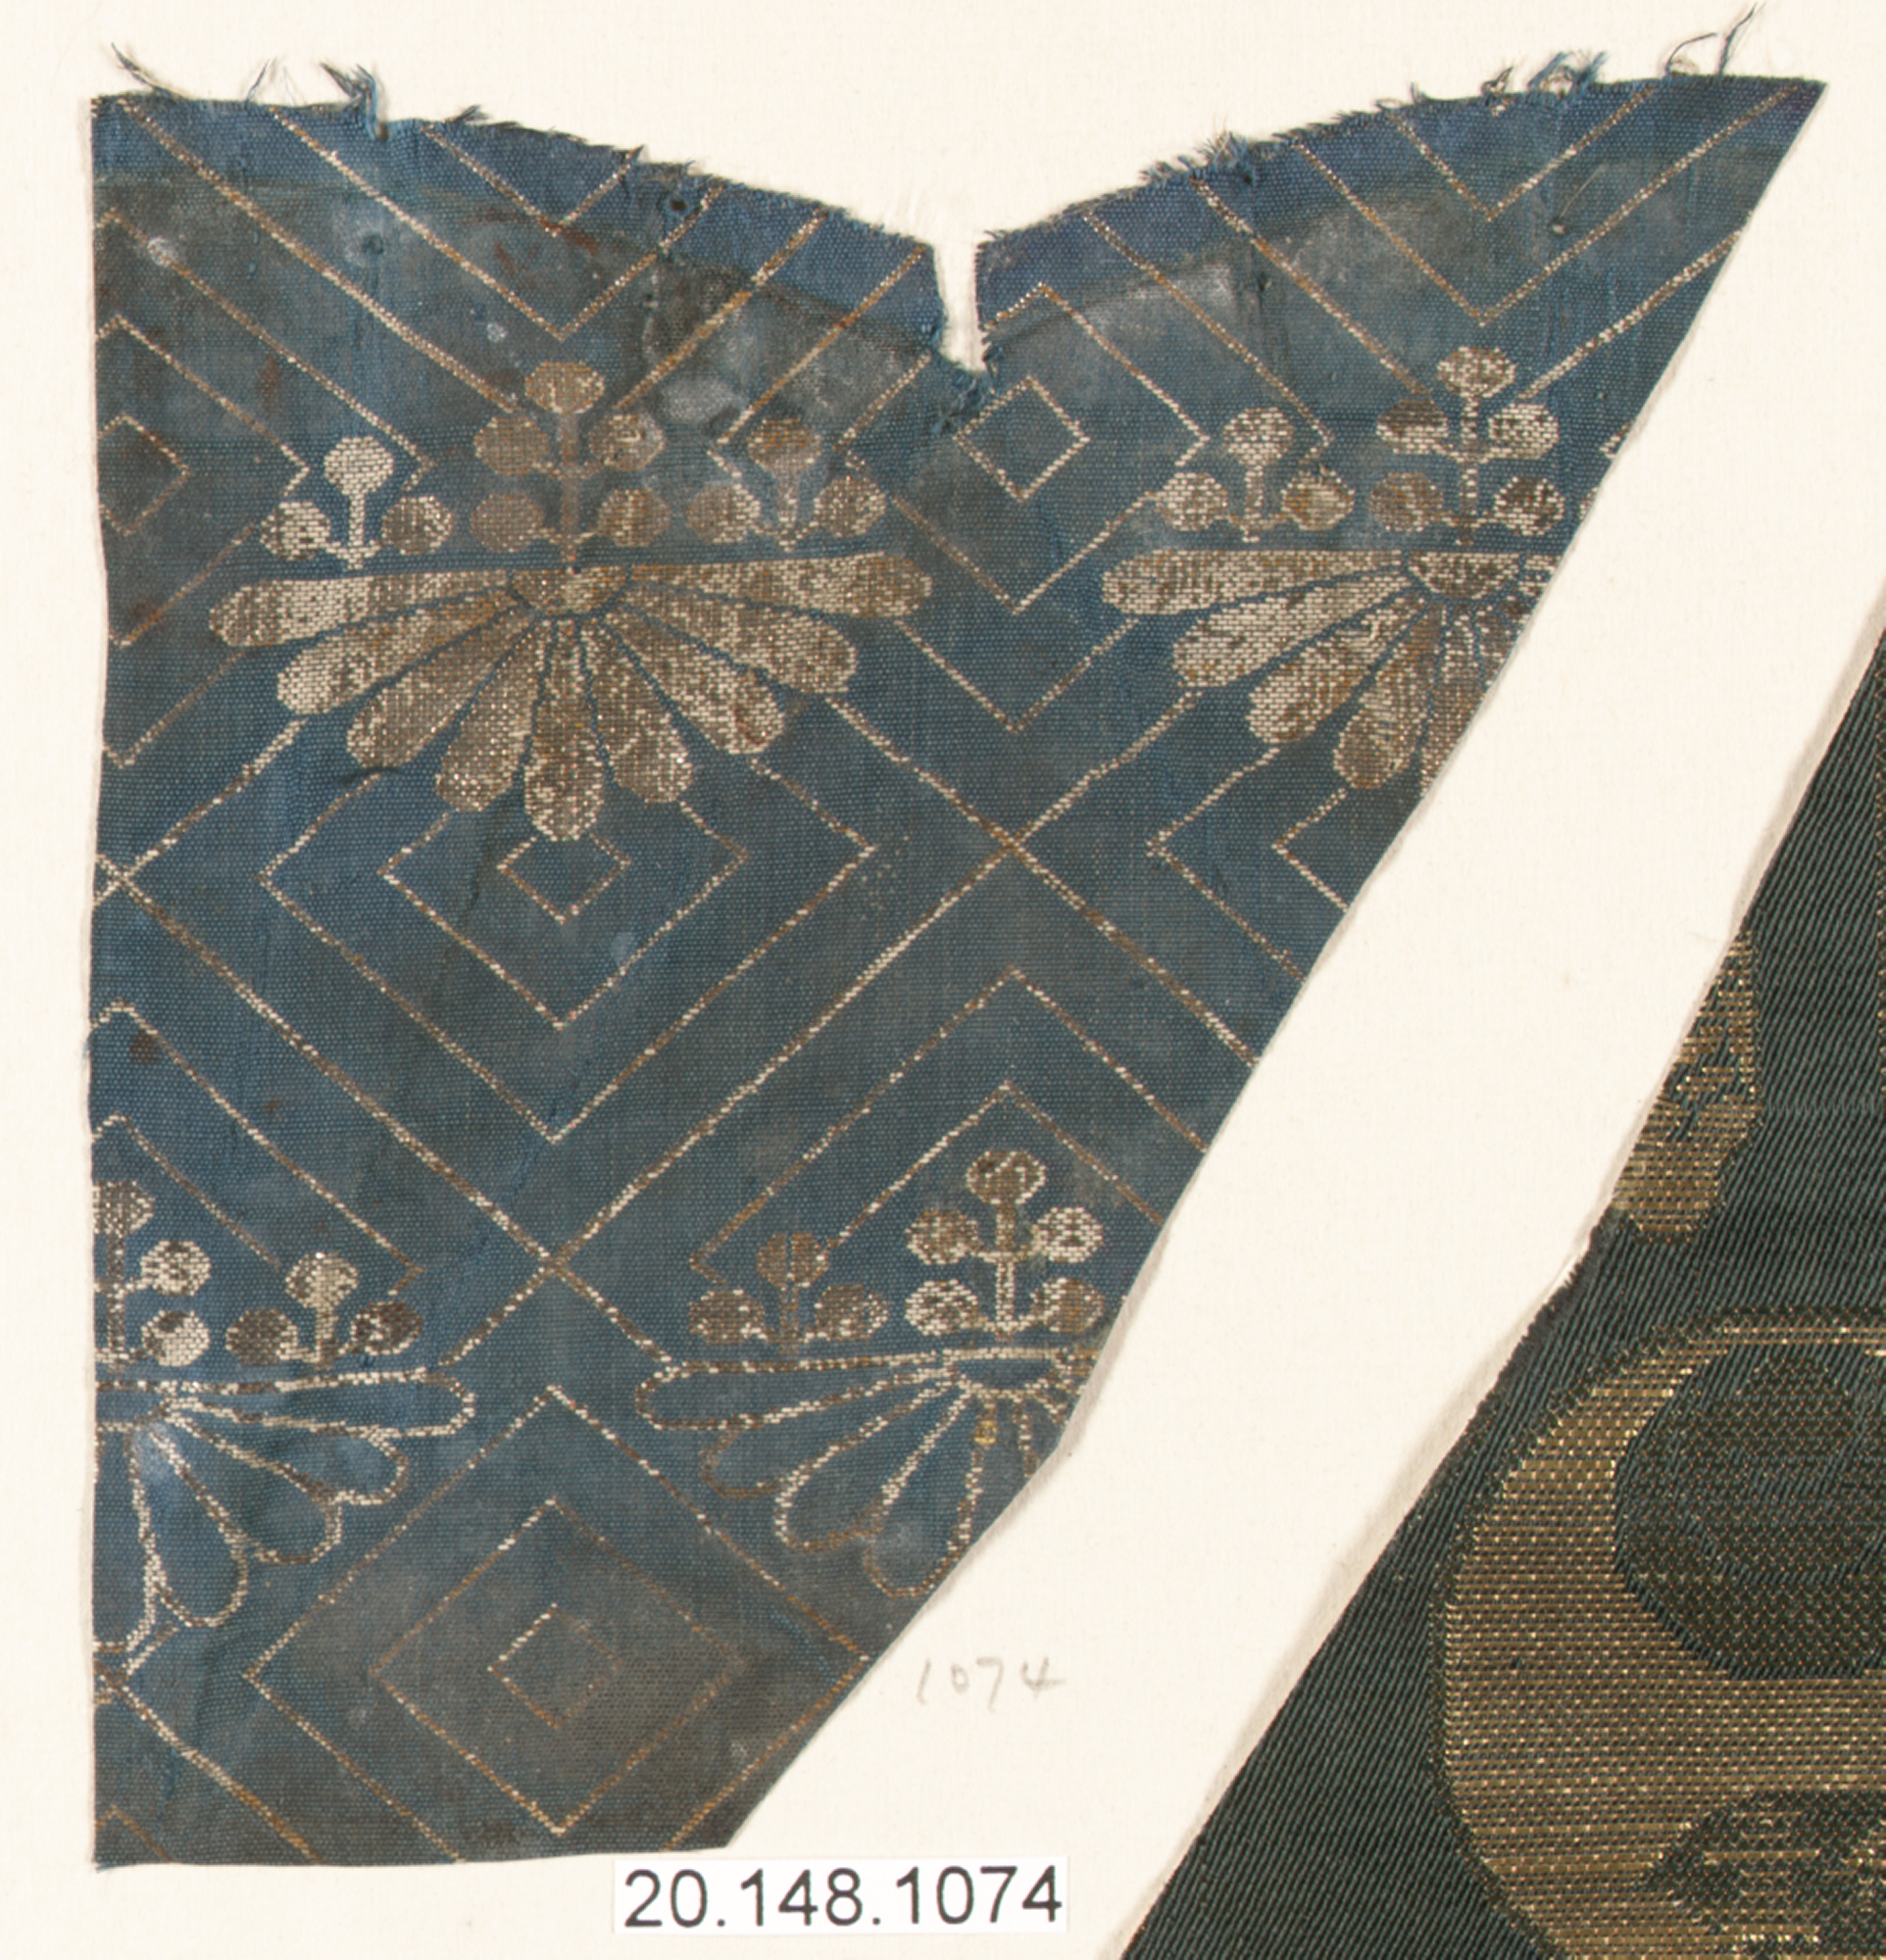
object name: piece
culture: japanese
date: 1601-1700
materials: silk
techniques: compound weave